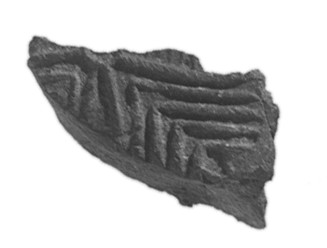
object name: sealing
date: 2030-1640 BCE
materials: clay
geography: egypt